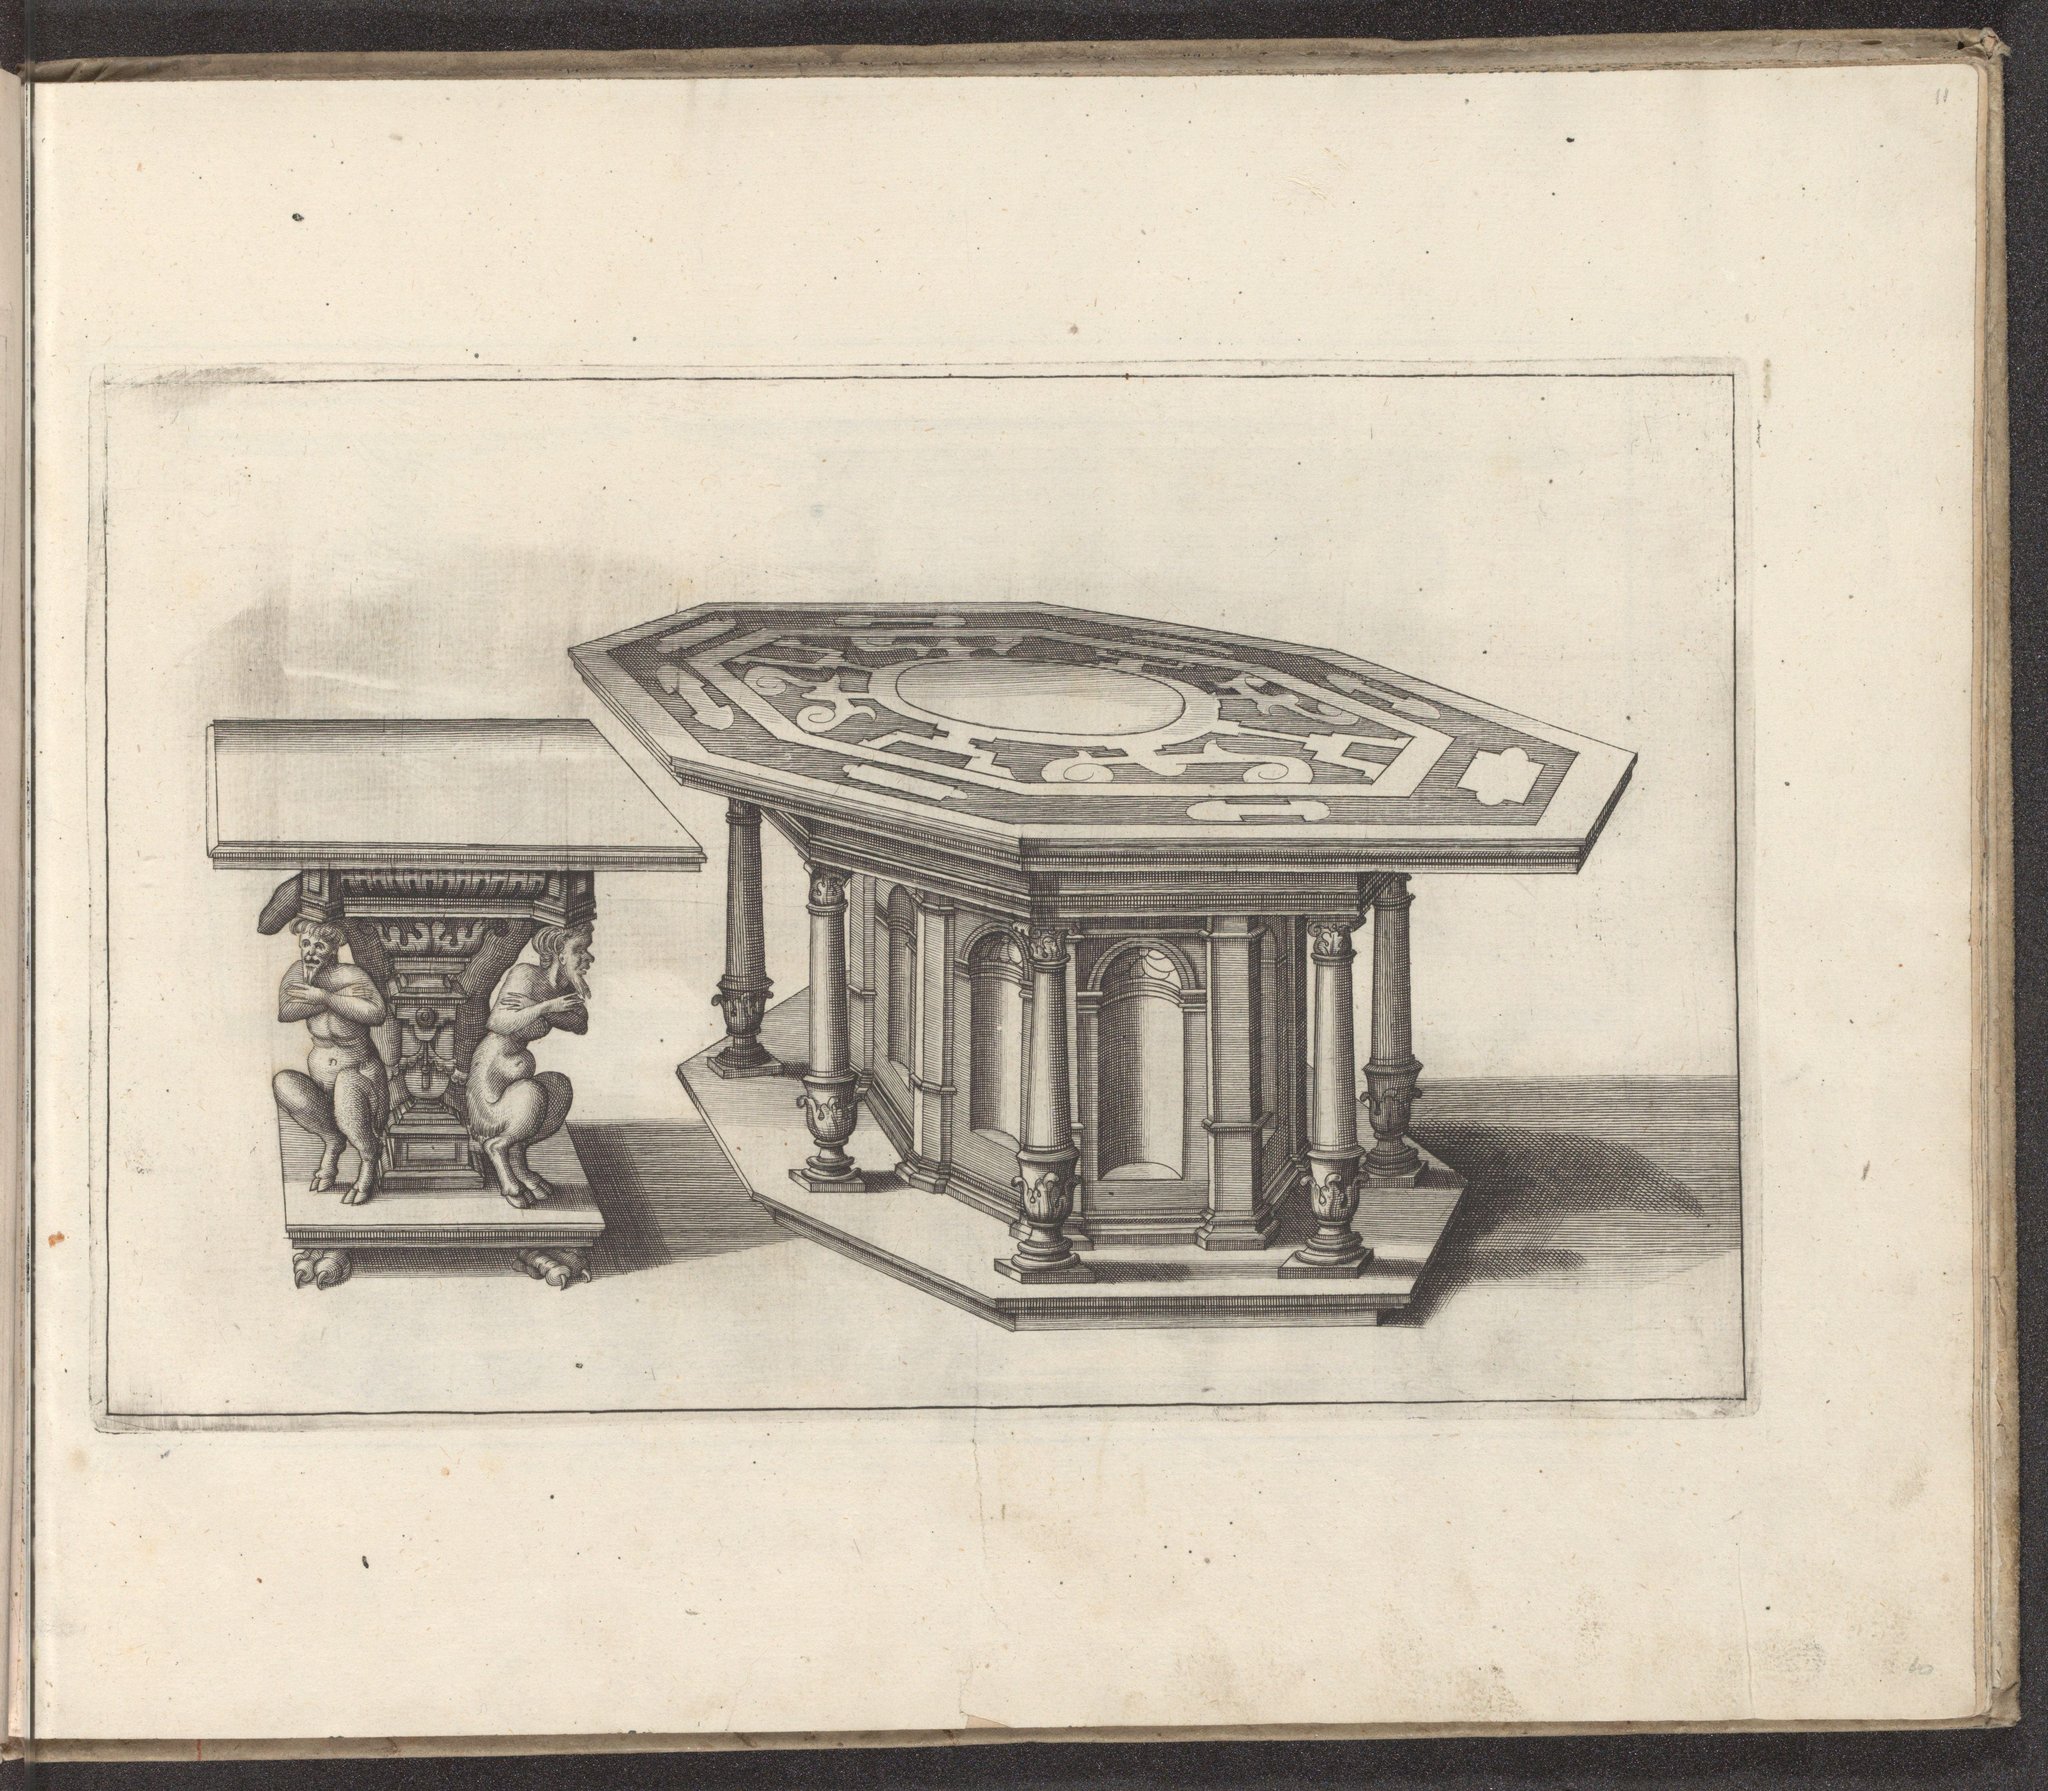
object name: ornament print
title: Verscheidene Schreinwercke / Plusieurs Menuiseries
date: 1658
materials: paper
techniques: engraving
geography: cologne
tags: table, satyr(s) (in general)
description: Twee tafels. Links een kleine vierkante tafel. Het blad wordt ondersteund door saters. Rechts een grote tafel. Het blad en het voetstuk hebben een hexagonale vorm. Het blad wordt ondersteund door losstaande pilaren. De prent maakt deel uit van een album.